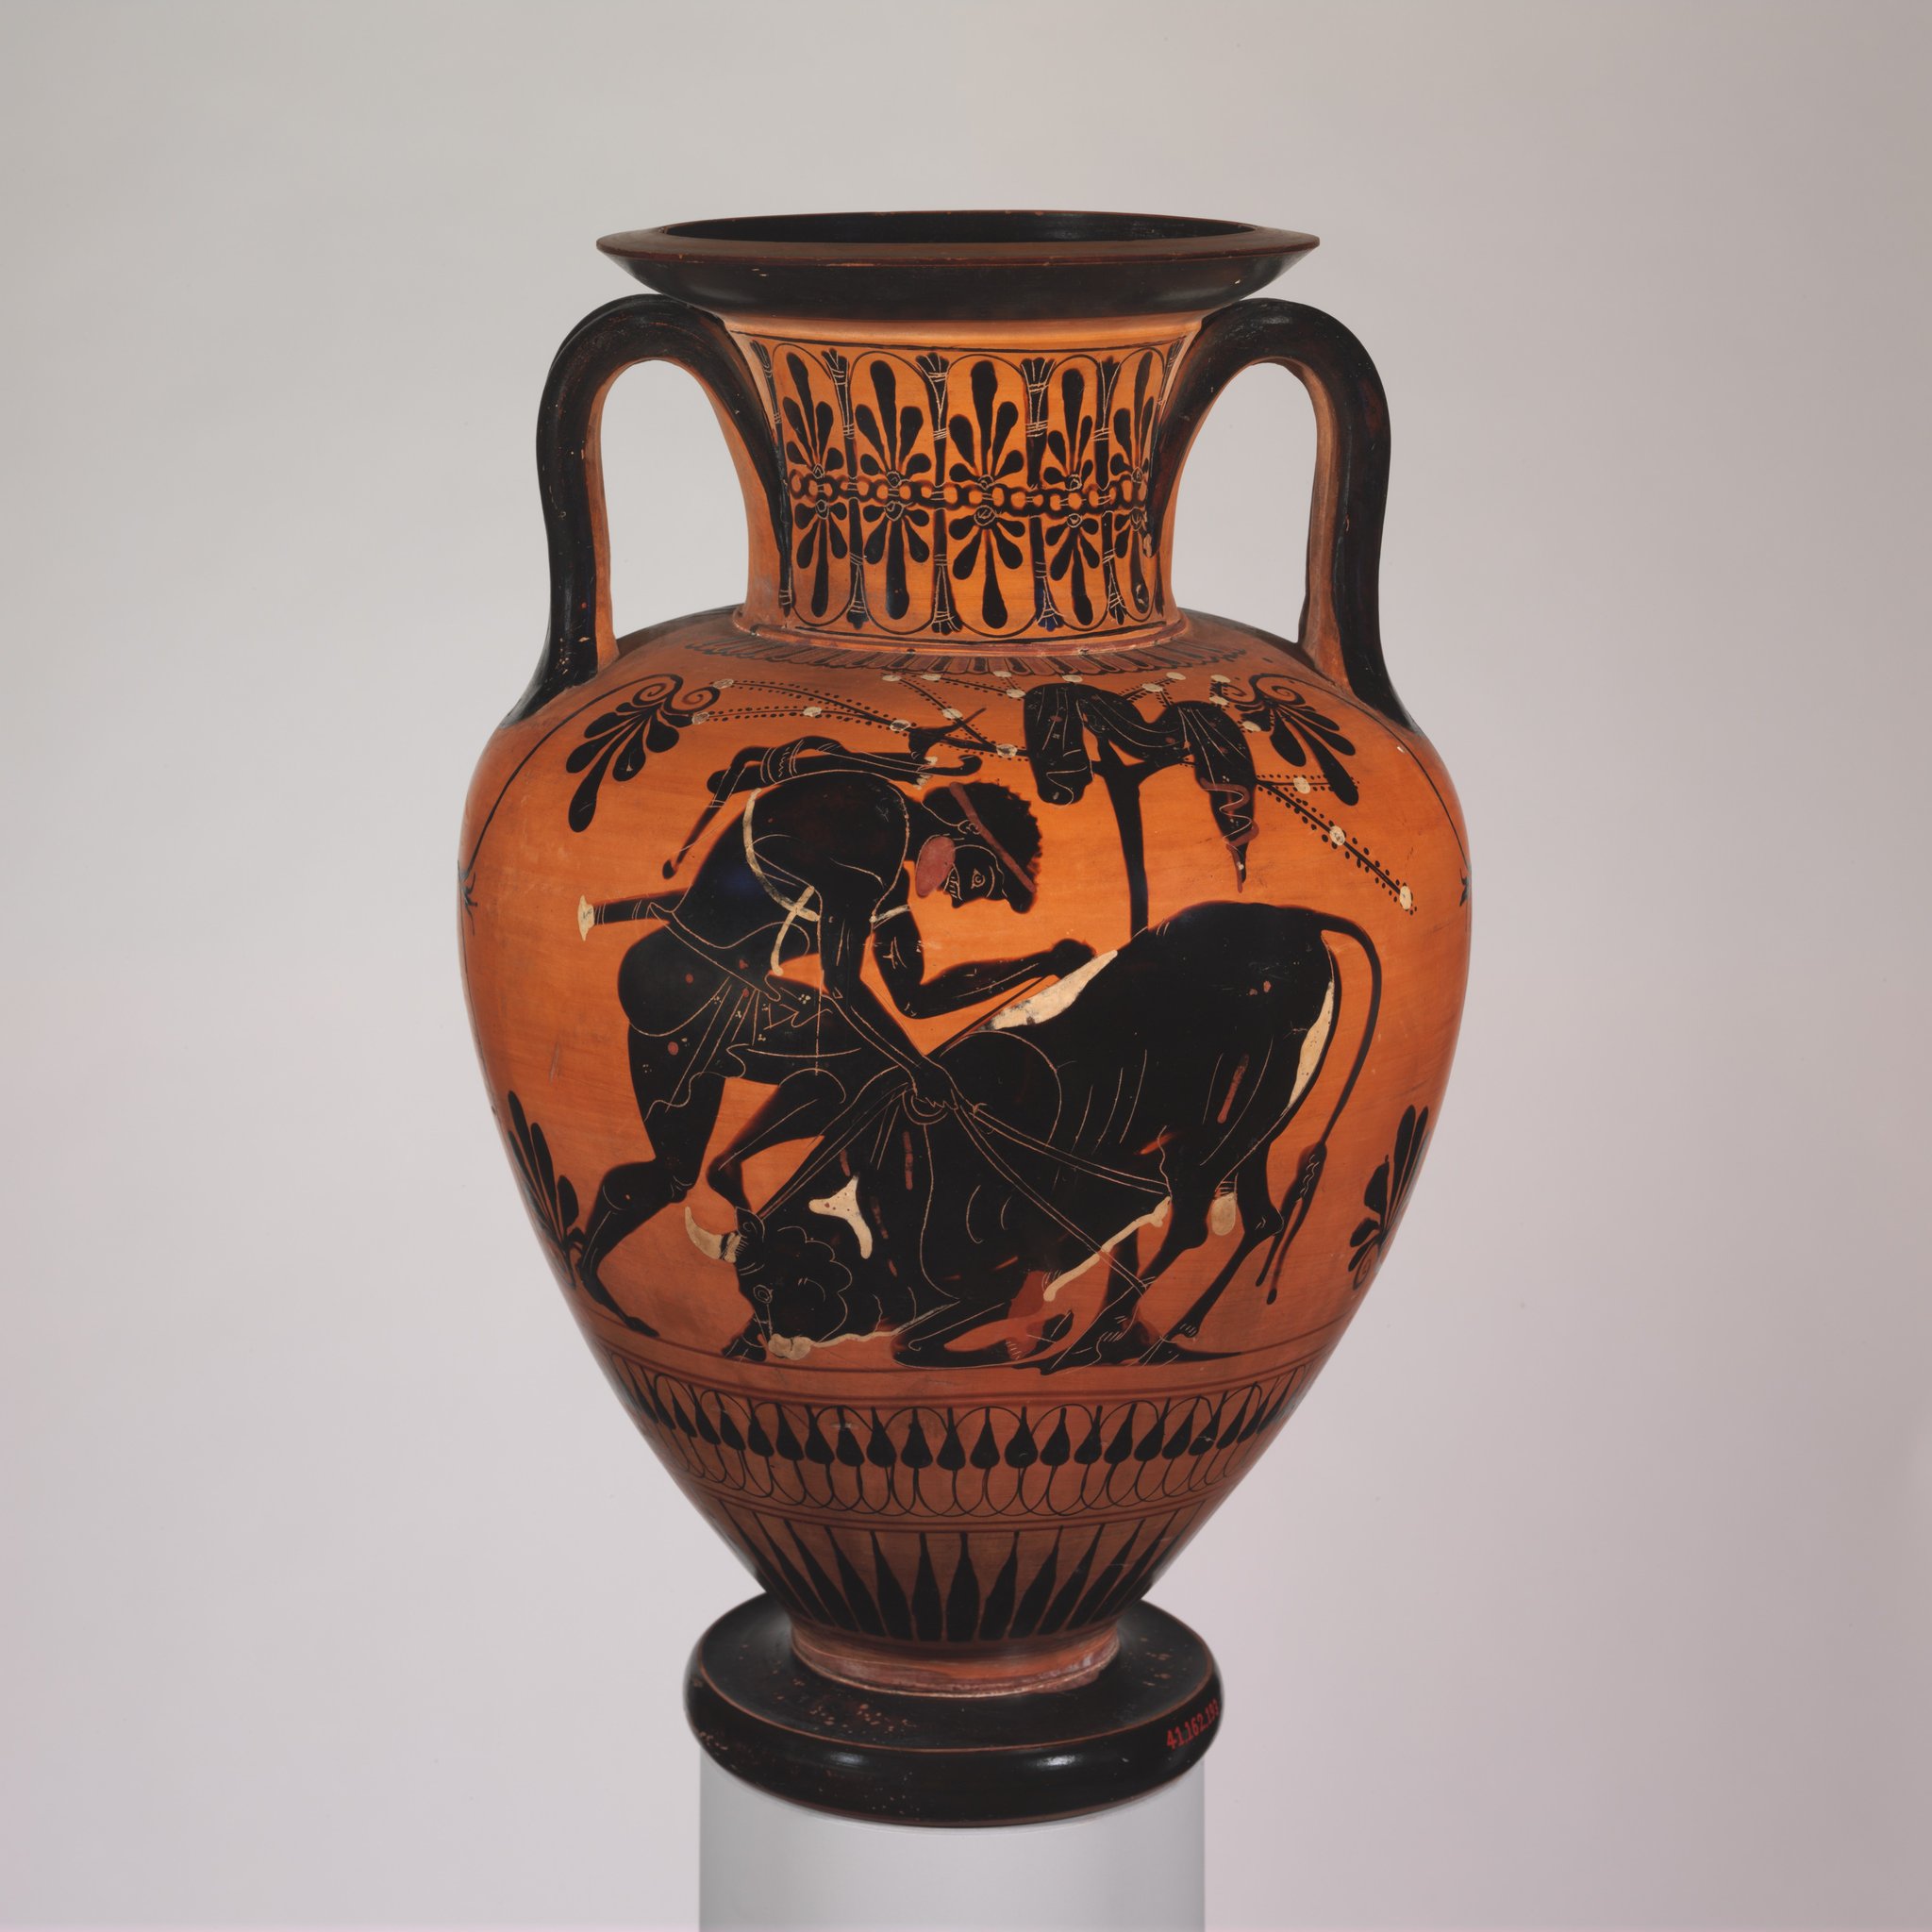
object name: neck amphora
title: Terracotta neck-amphora (jar) with Herakles and a bull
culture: greek, attic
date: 520-510 BCE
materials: terracotta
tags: bulls,herakles